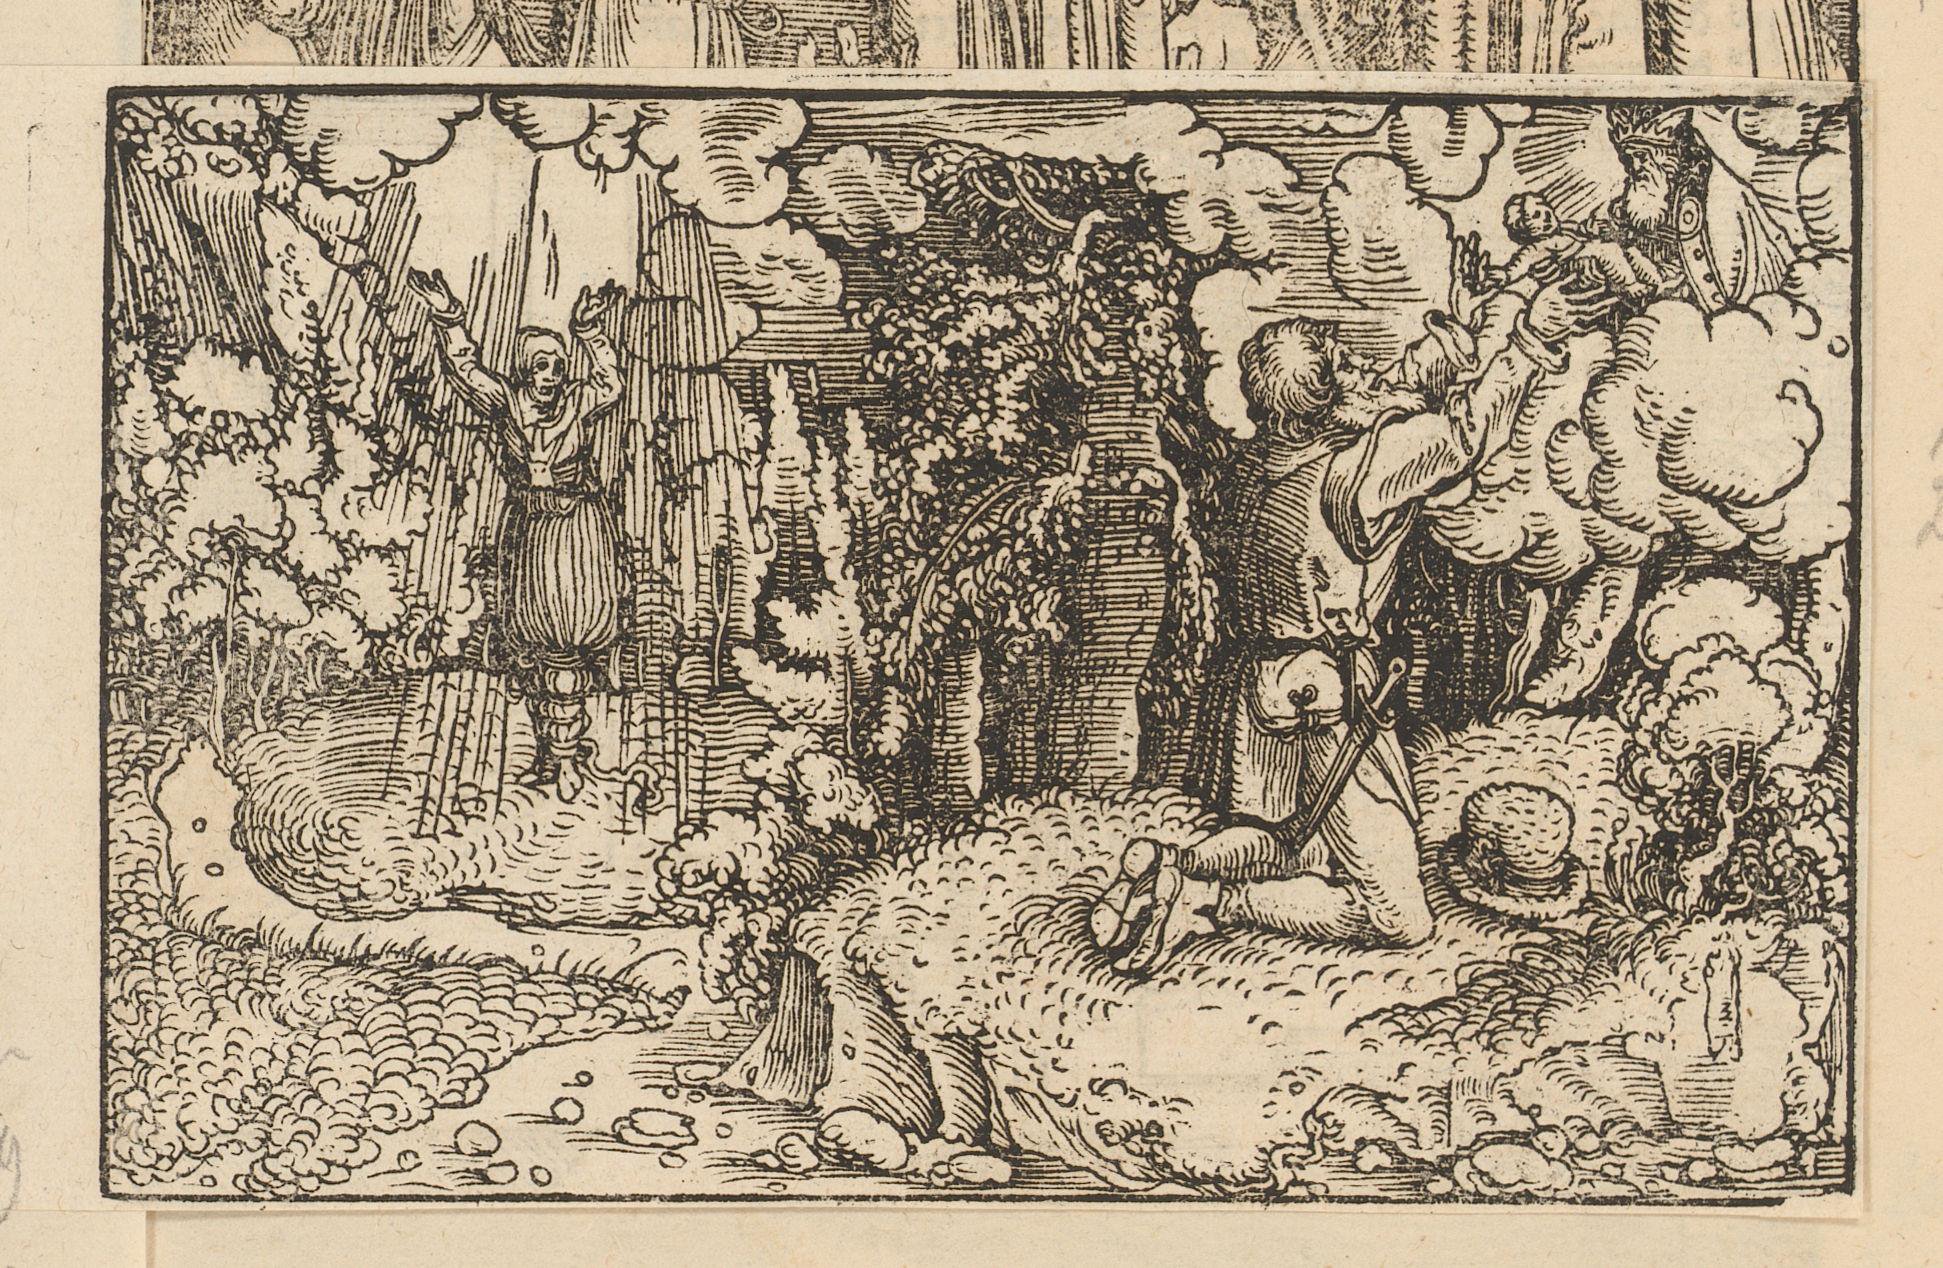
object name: print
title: Vrouw wordt in de hemel opgenomen en een man ontvangt een kind uit de wolken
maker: Anonymous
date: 1514-1532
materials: paper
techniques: letterpress printing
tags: sterility; barren woman, (ascent into) heaven, supernatural beings as bringers of babies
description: Deze prent is gebruikt in: Petrarca, Francesco. Von der Artzney bayder Glück, des guten und widerwertigen: unnd weß sich ain yeder inn Gelück und Unglück halten sol (...). Augsburg: Heinrich Steiner, 1532. Deze uitgave is ook bekend onder de titel 'Trostspiegel in Glück und Unglück'.